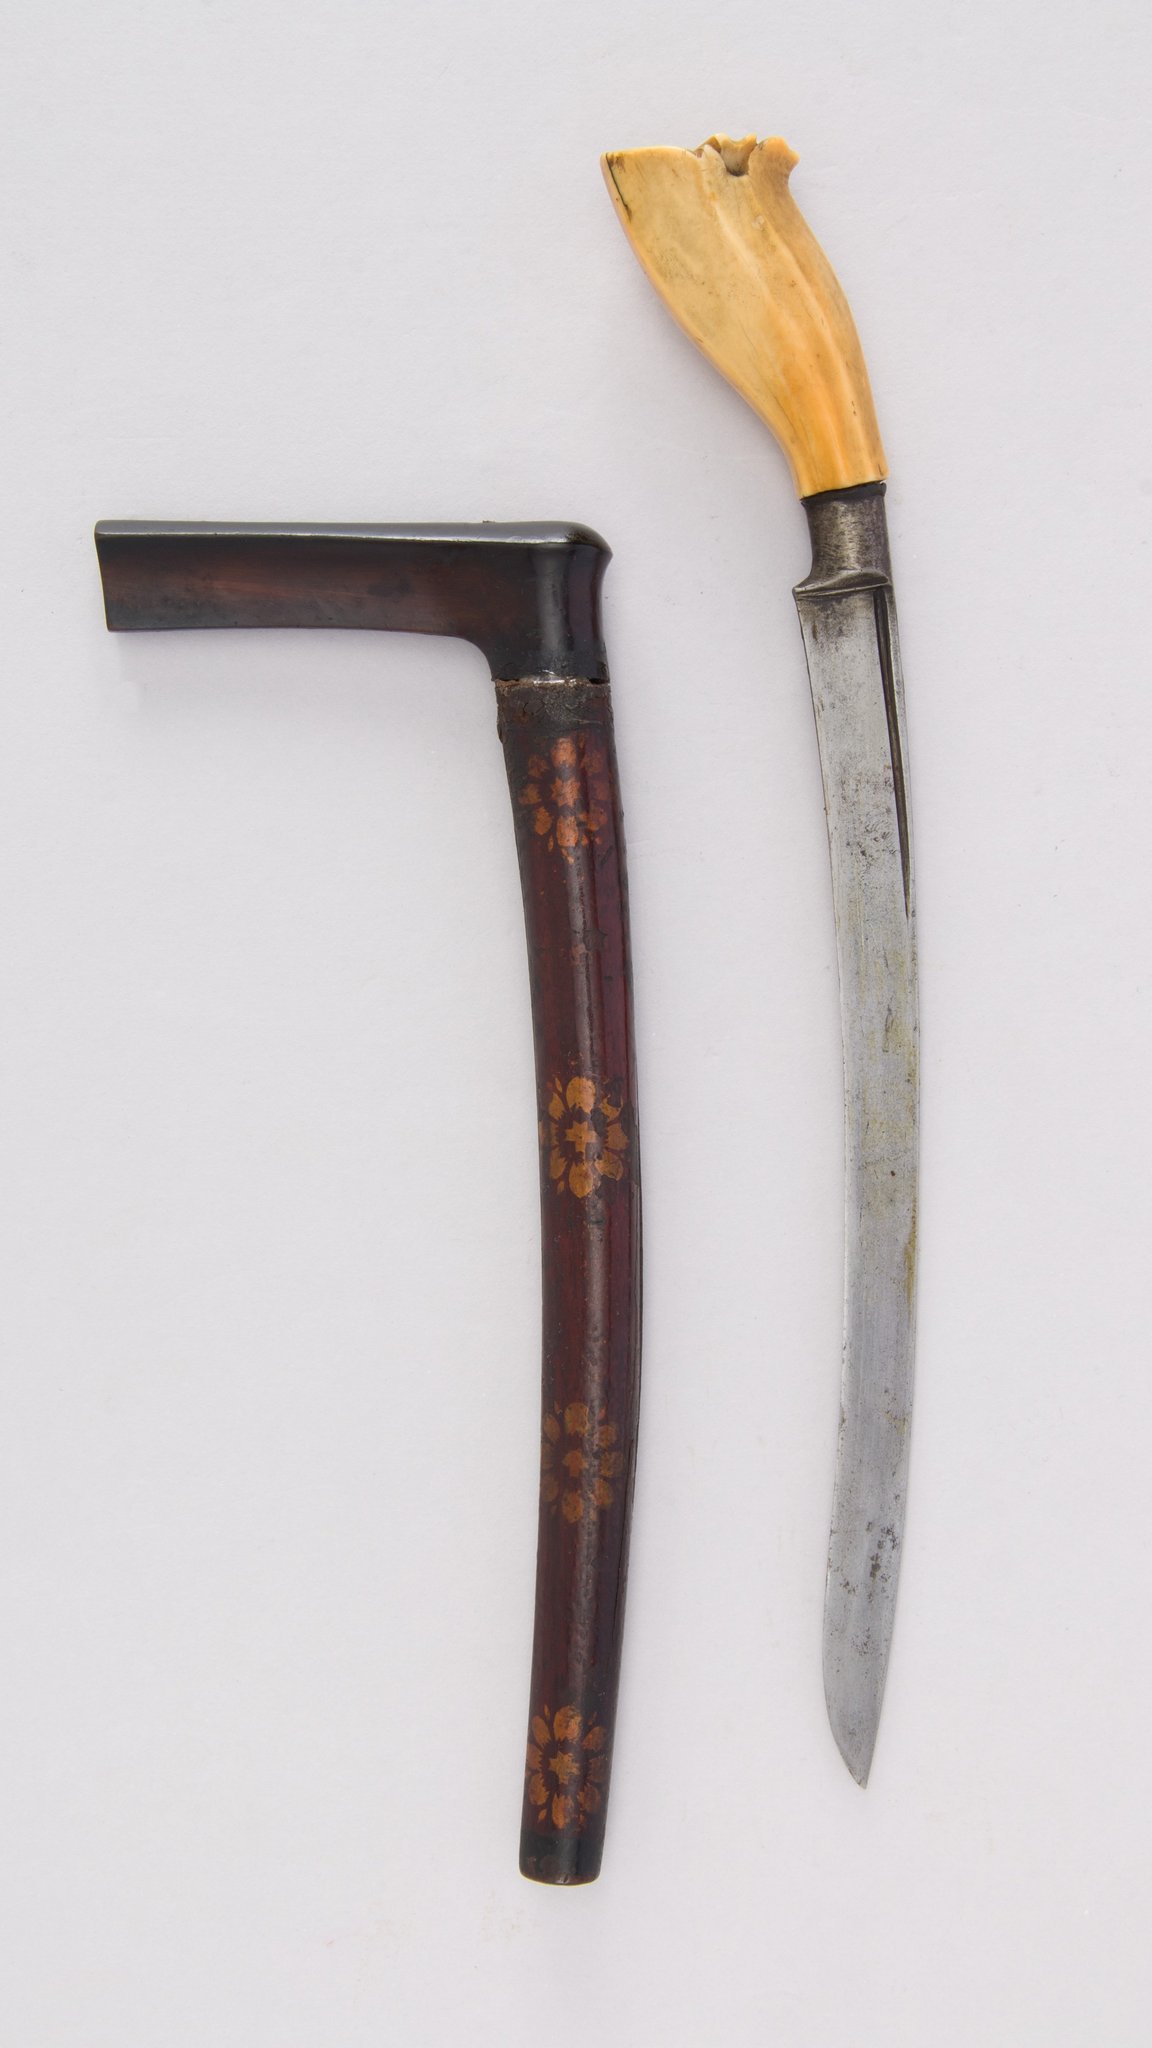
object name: knife bade bade with sheath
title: Knife (Bade-bade) with Sheath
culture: malayan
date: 1701-1900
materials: horn, ivory, steel, wood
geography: malaysia